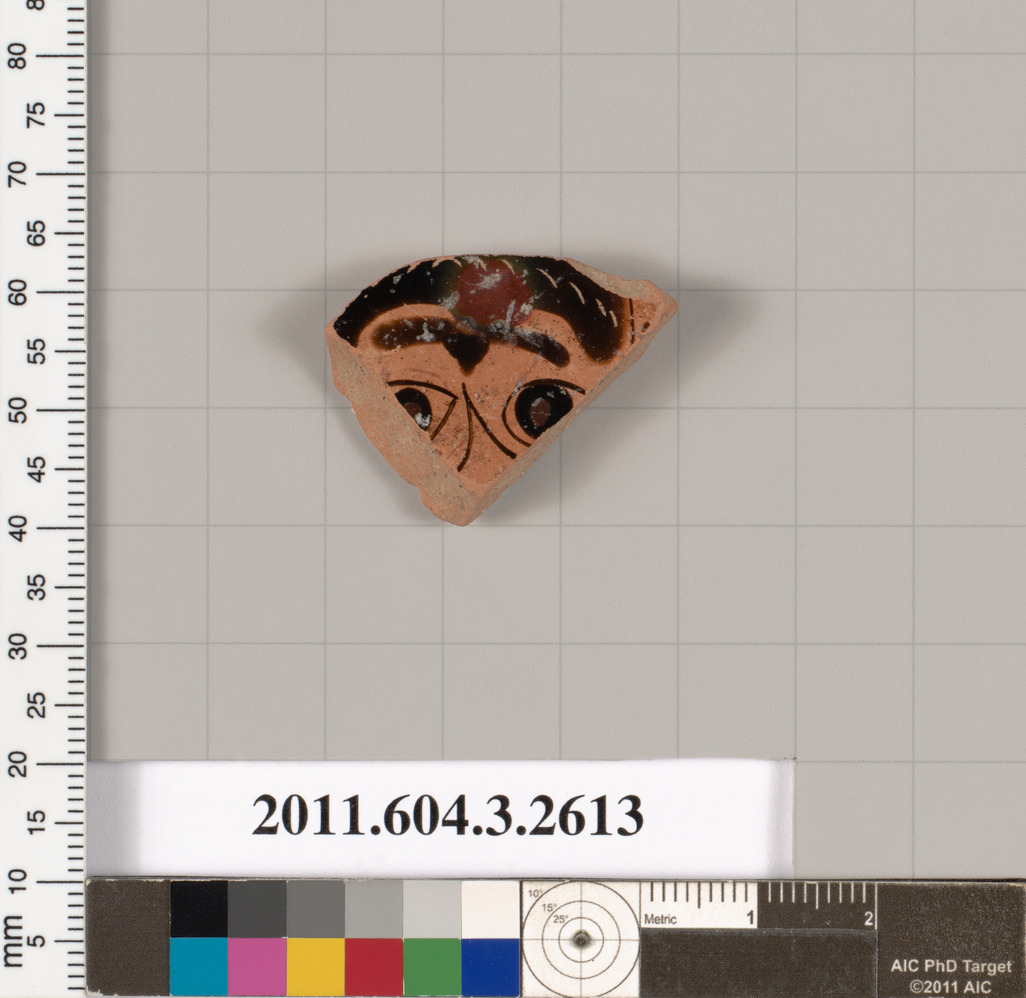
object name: kylix fragment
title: Terracotta fragment of a kylix (drinking cup)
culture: greek, attic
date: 550-526 BCE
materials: terracotta